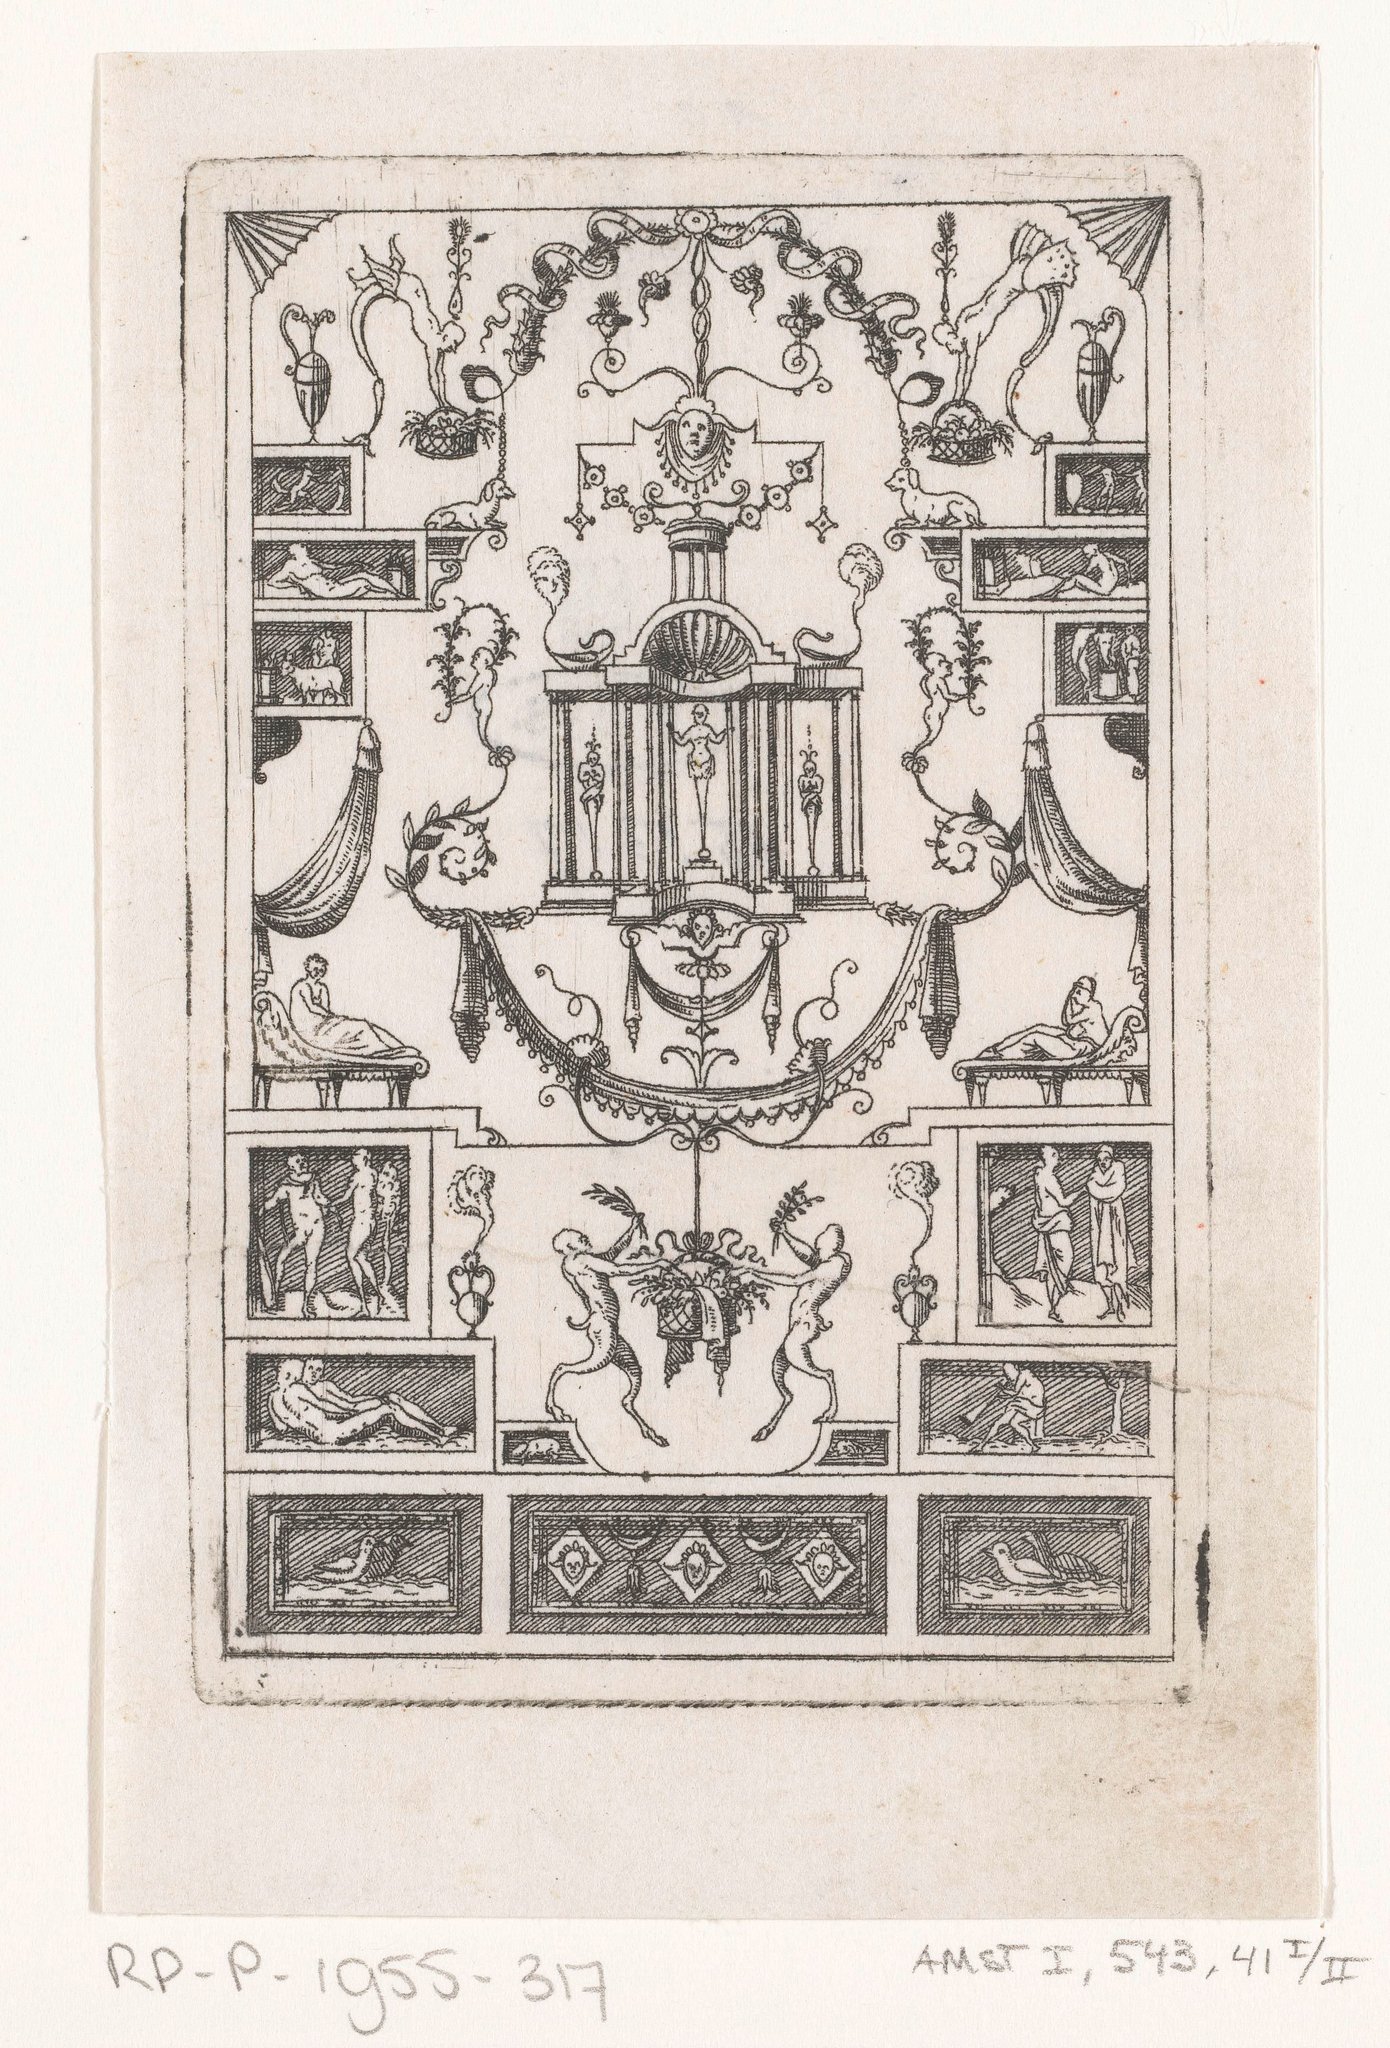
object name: print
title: Compositie met saters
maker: Anonymous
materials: paper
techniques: etching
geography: paris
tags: frequently used ornamental compositions, satyr(s) (in general)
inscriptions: collector's mark: Lugt 2228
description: Een decoratieve compositie. Midden onder staan twee saters aan weerszijden van een mand met bladranken waar een doek overheen ligt. De mand hangt aan een draperie onder een open gebouw waarin drie hermen staan. Zowel links als rechts van de draperie ligt een figuur op een sofa.